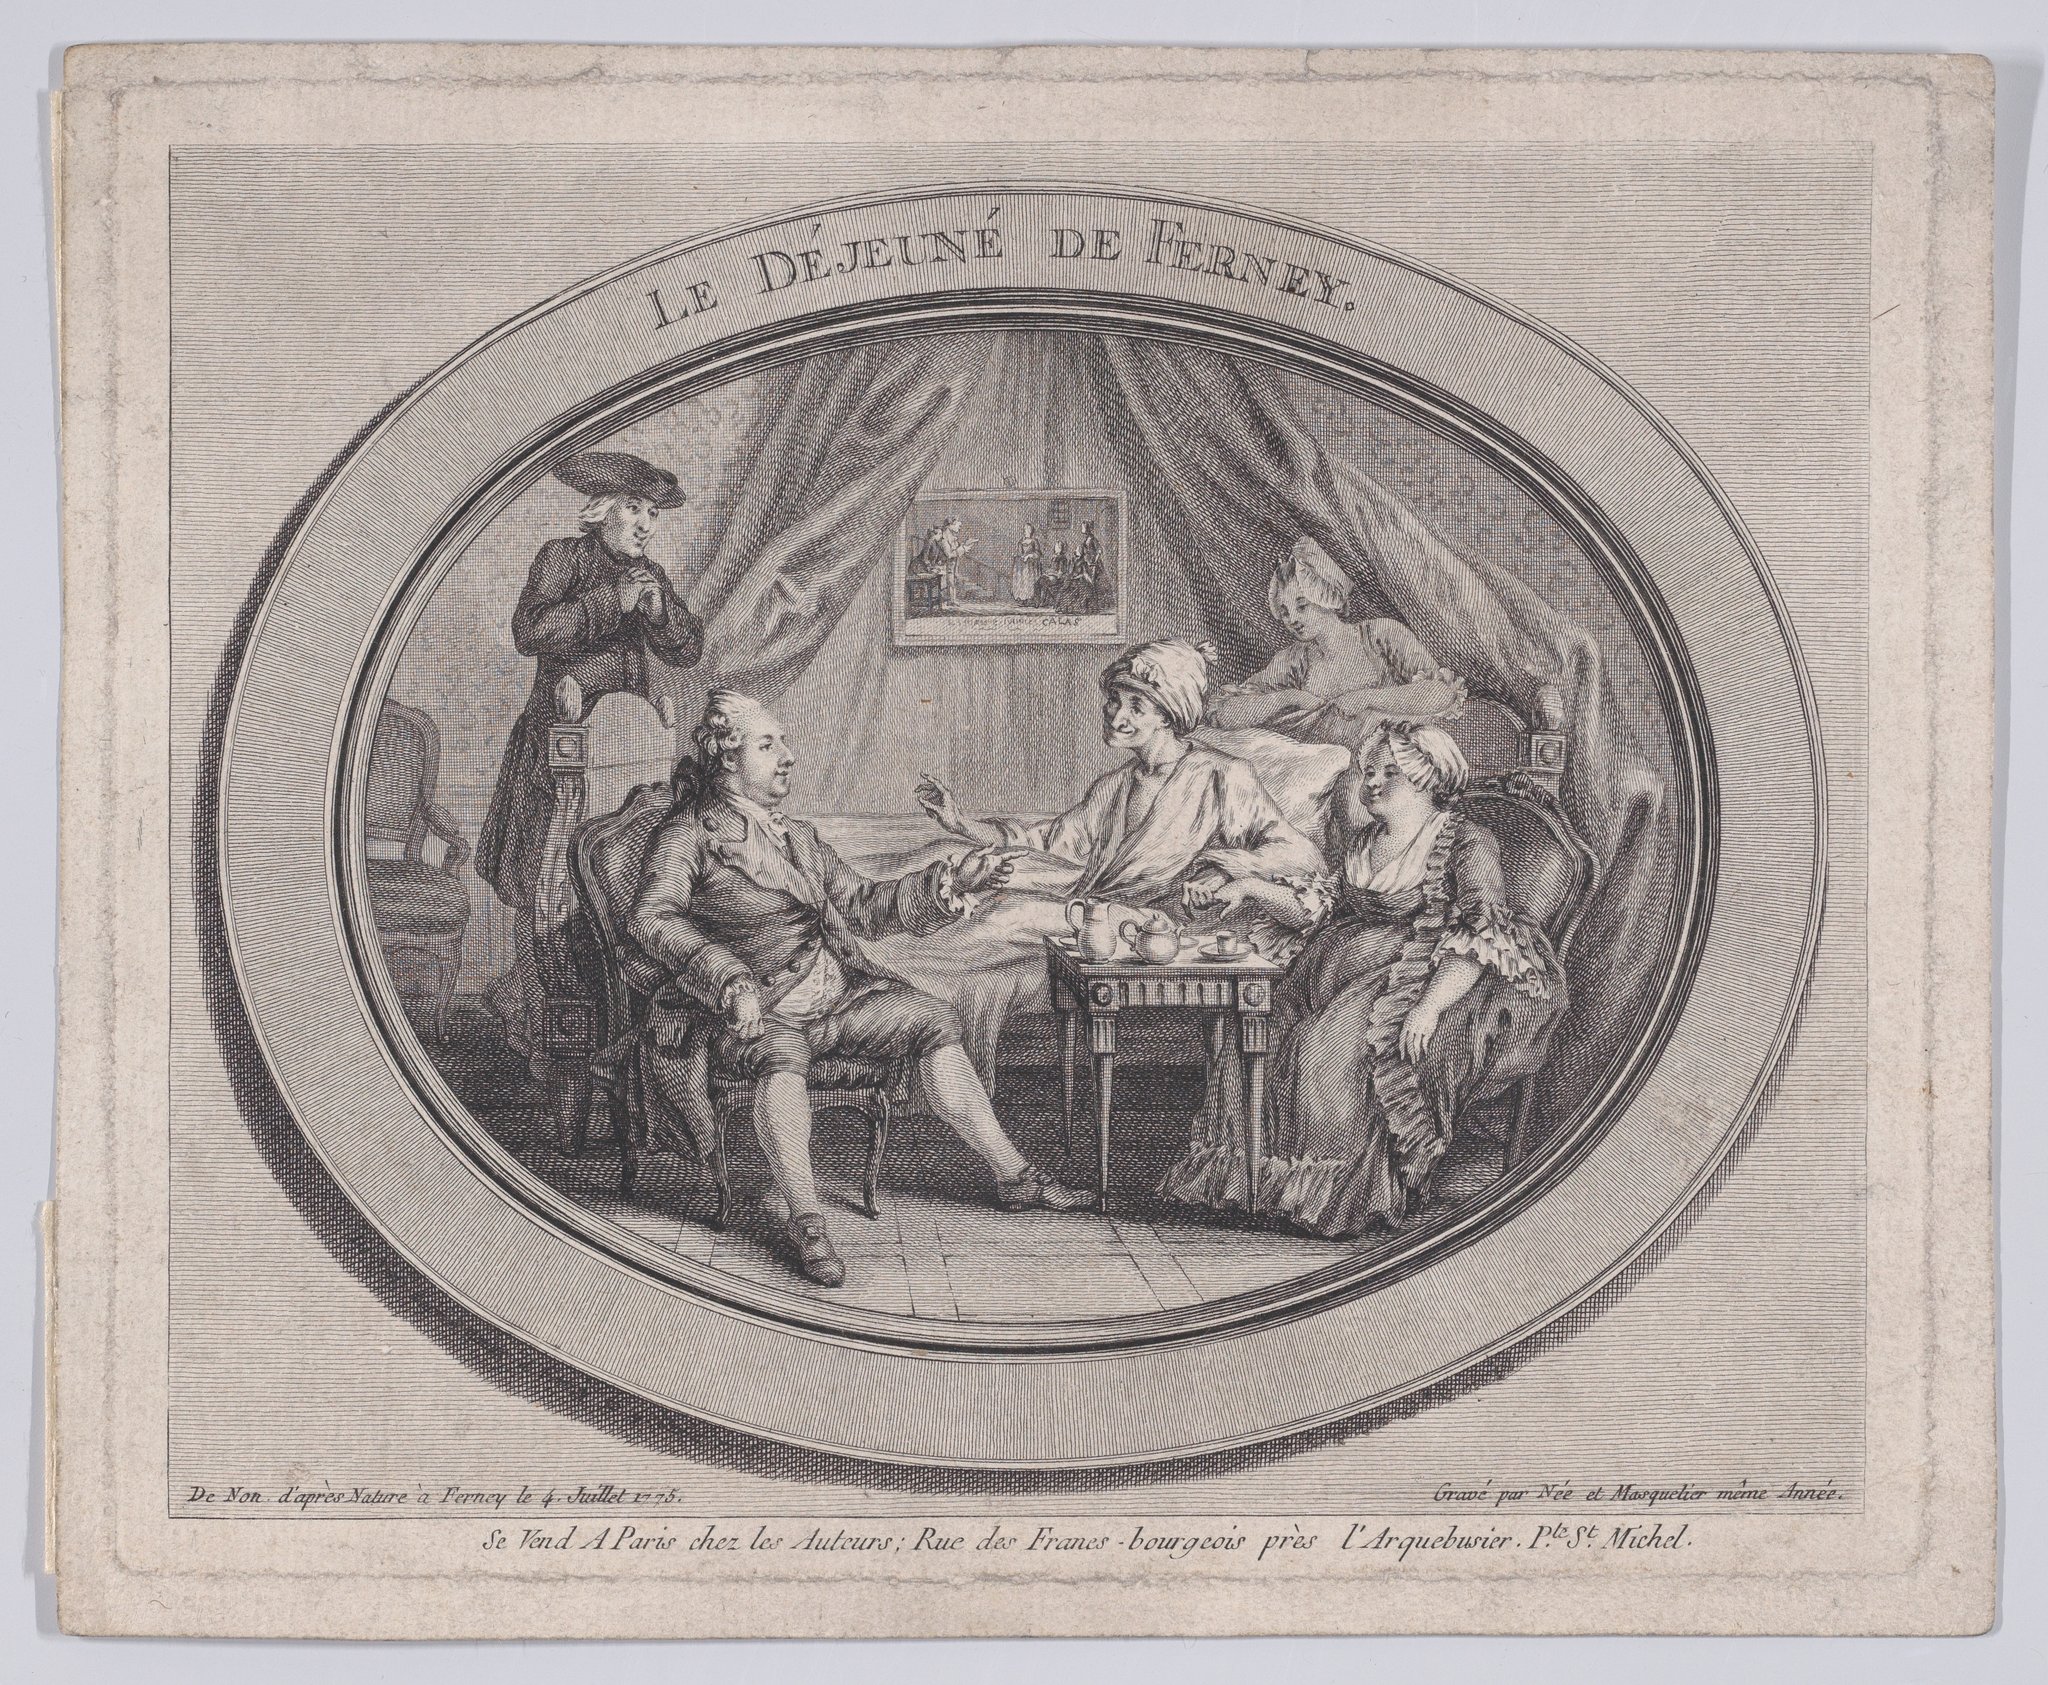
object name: print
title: Le Déjeuné de Ferney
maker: baron dominique vivant denon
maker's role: artist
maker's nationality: french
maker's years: 1747-1825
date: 1701-1833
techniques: engraving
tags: men,women,beds